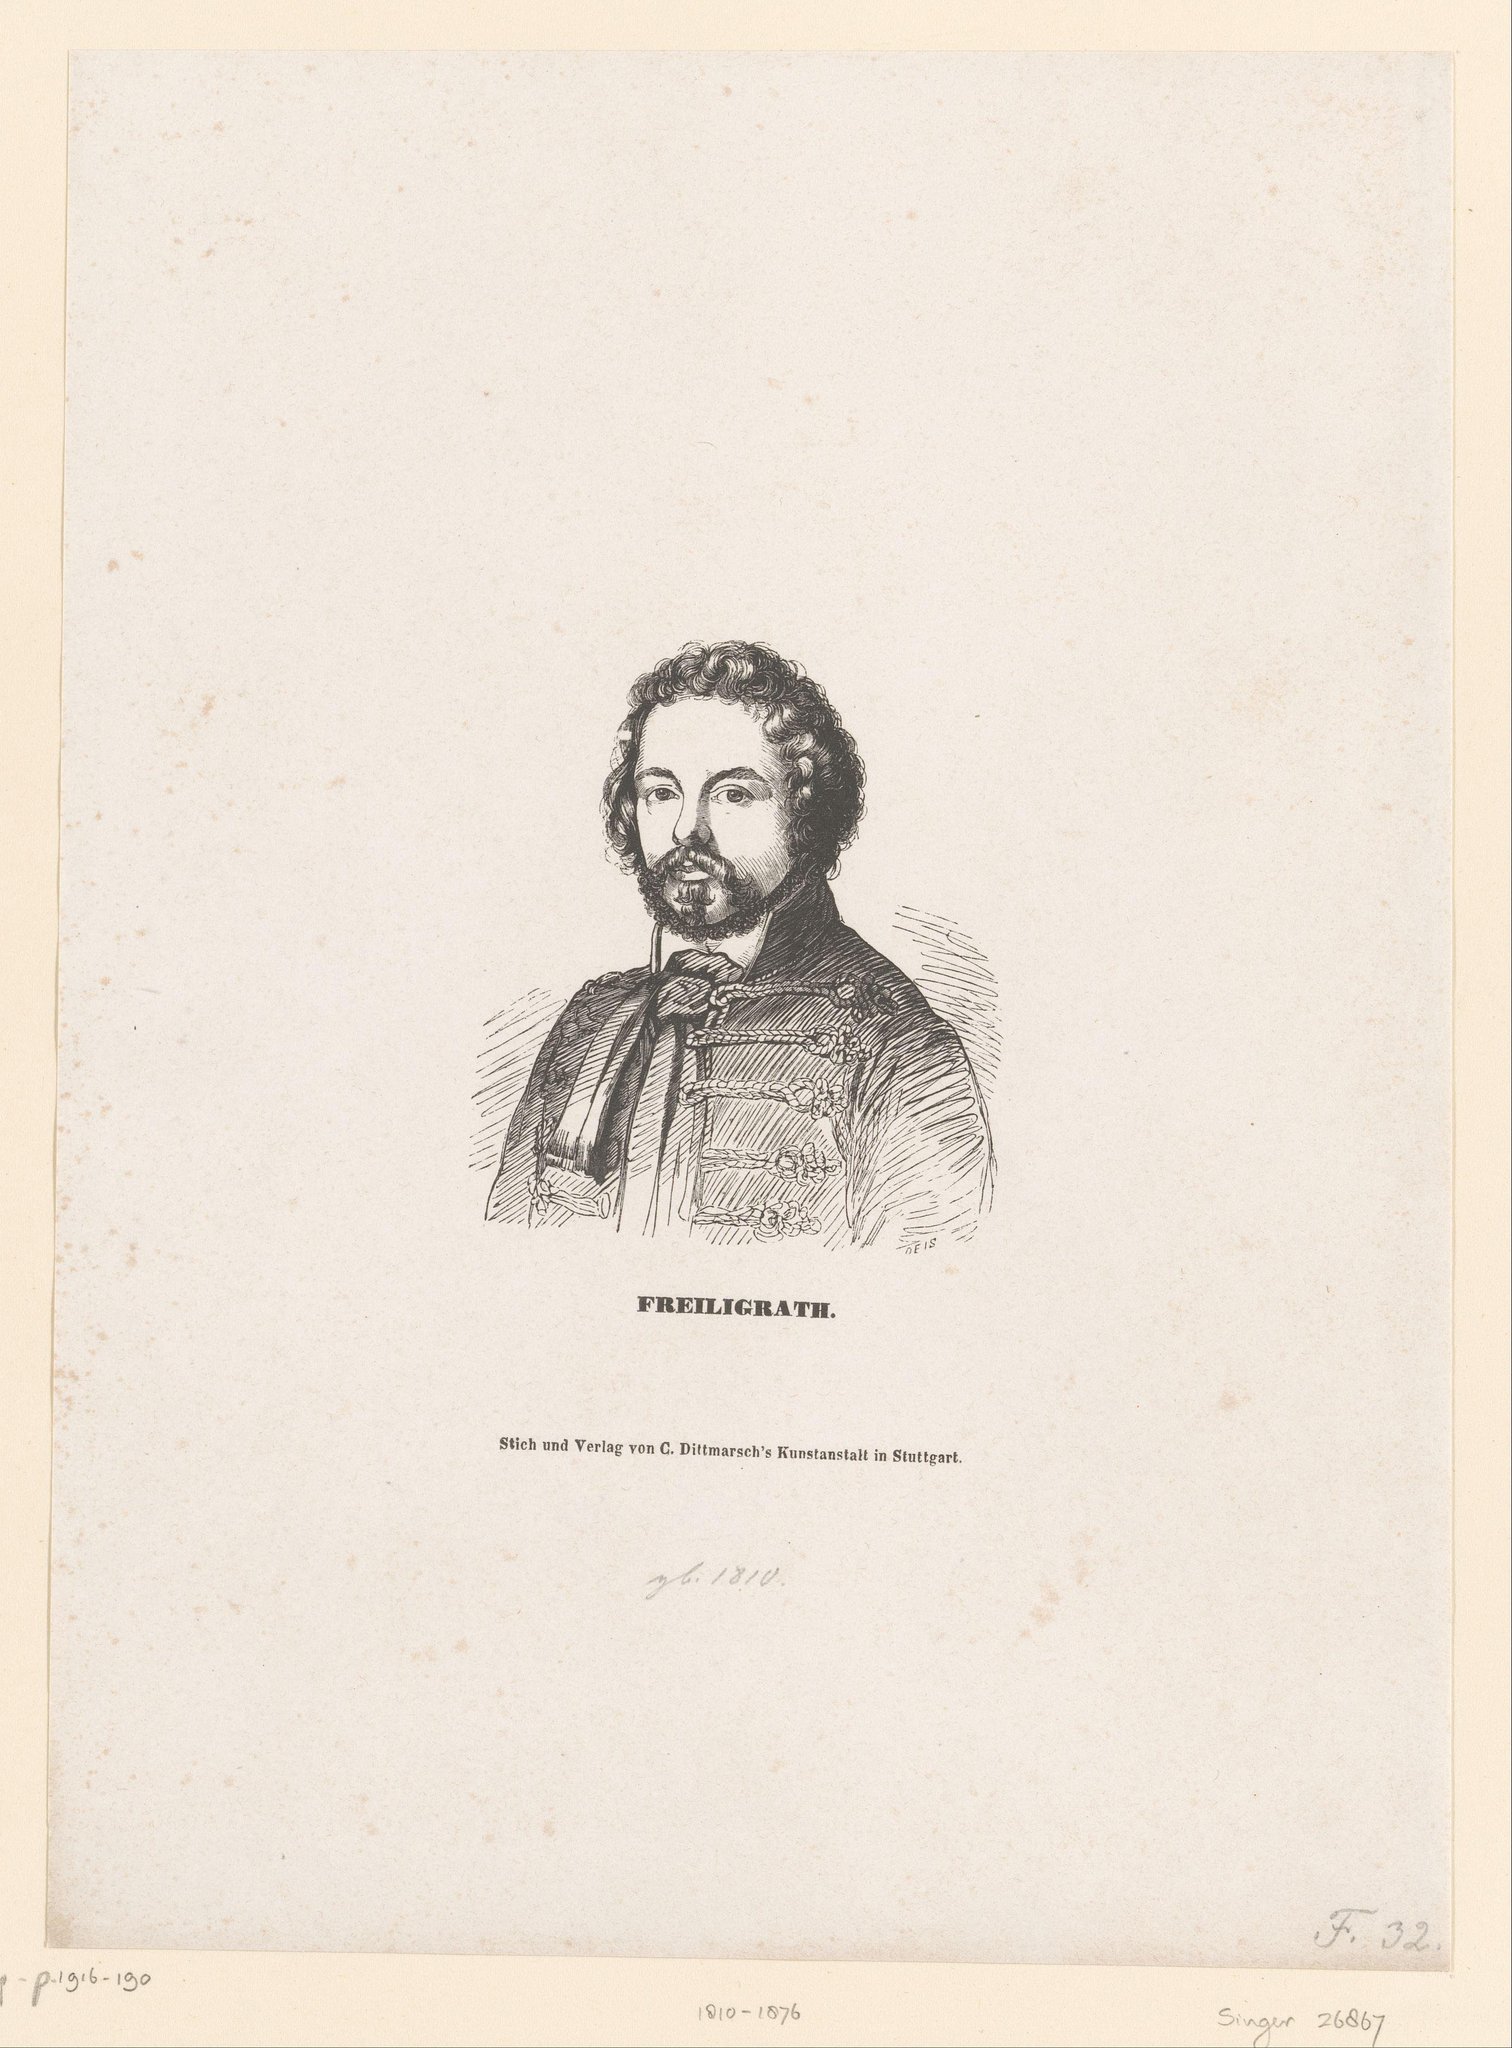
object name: print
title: Portret van de dichter Ferdinand Freiligrath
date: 1824-1900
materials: paper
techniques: engraving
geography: stuttgart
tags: ferdinand freiligrath, historical persons, writer, poet, author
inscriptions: collector's mark: Lugt 2228, date